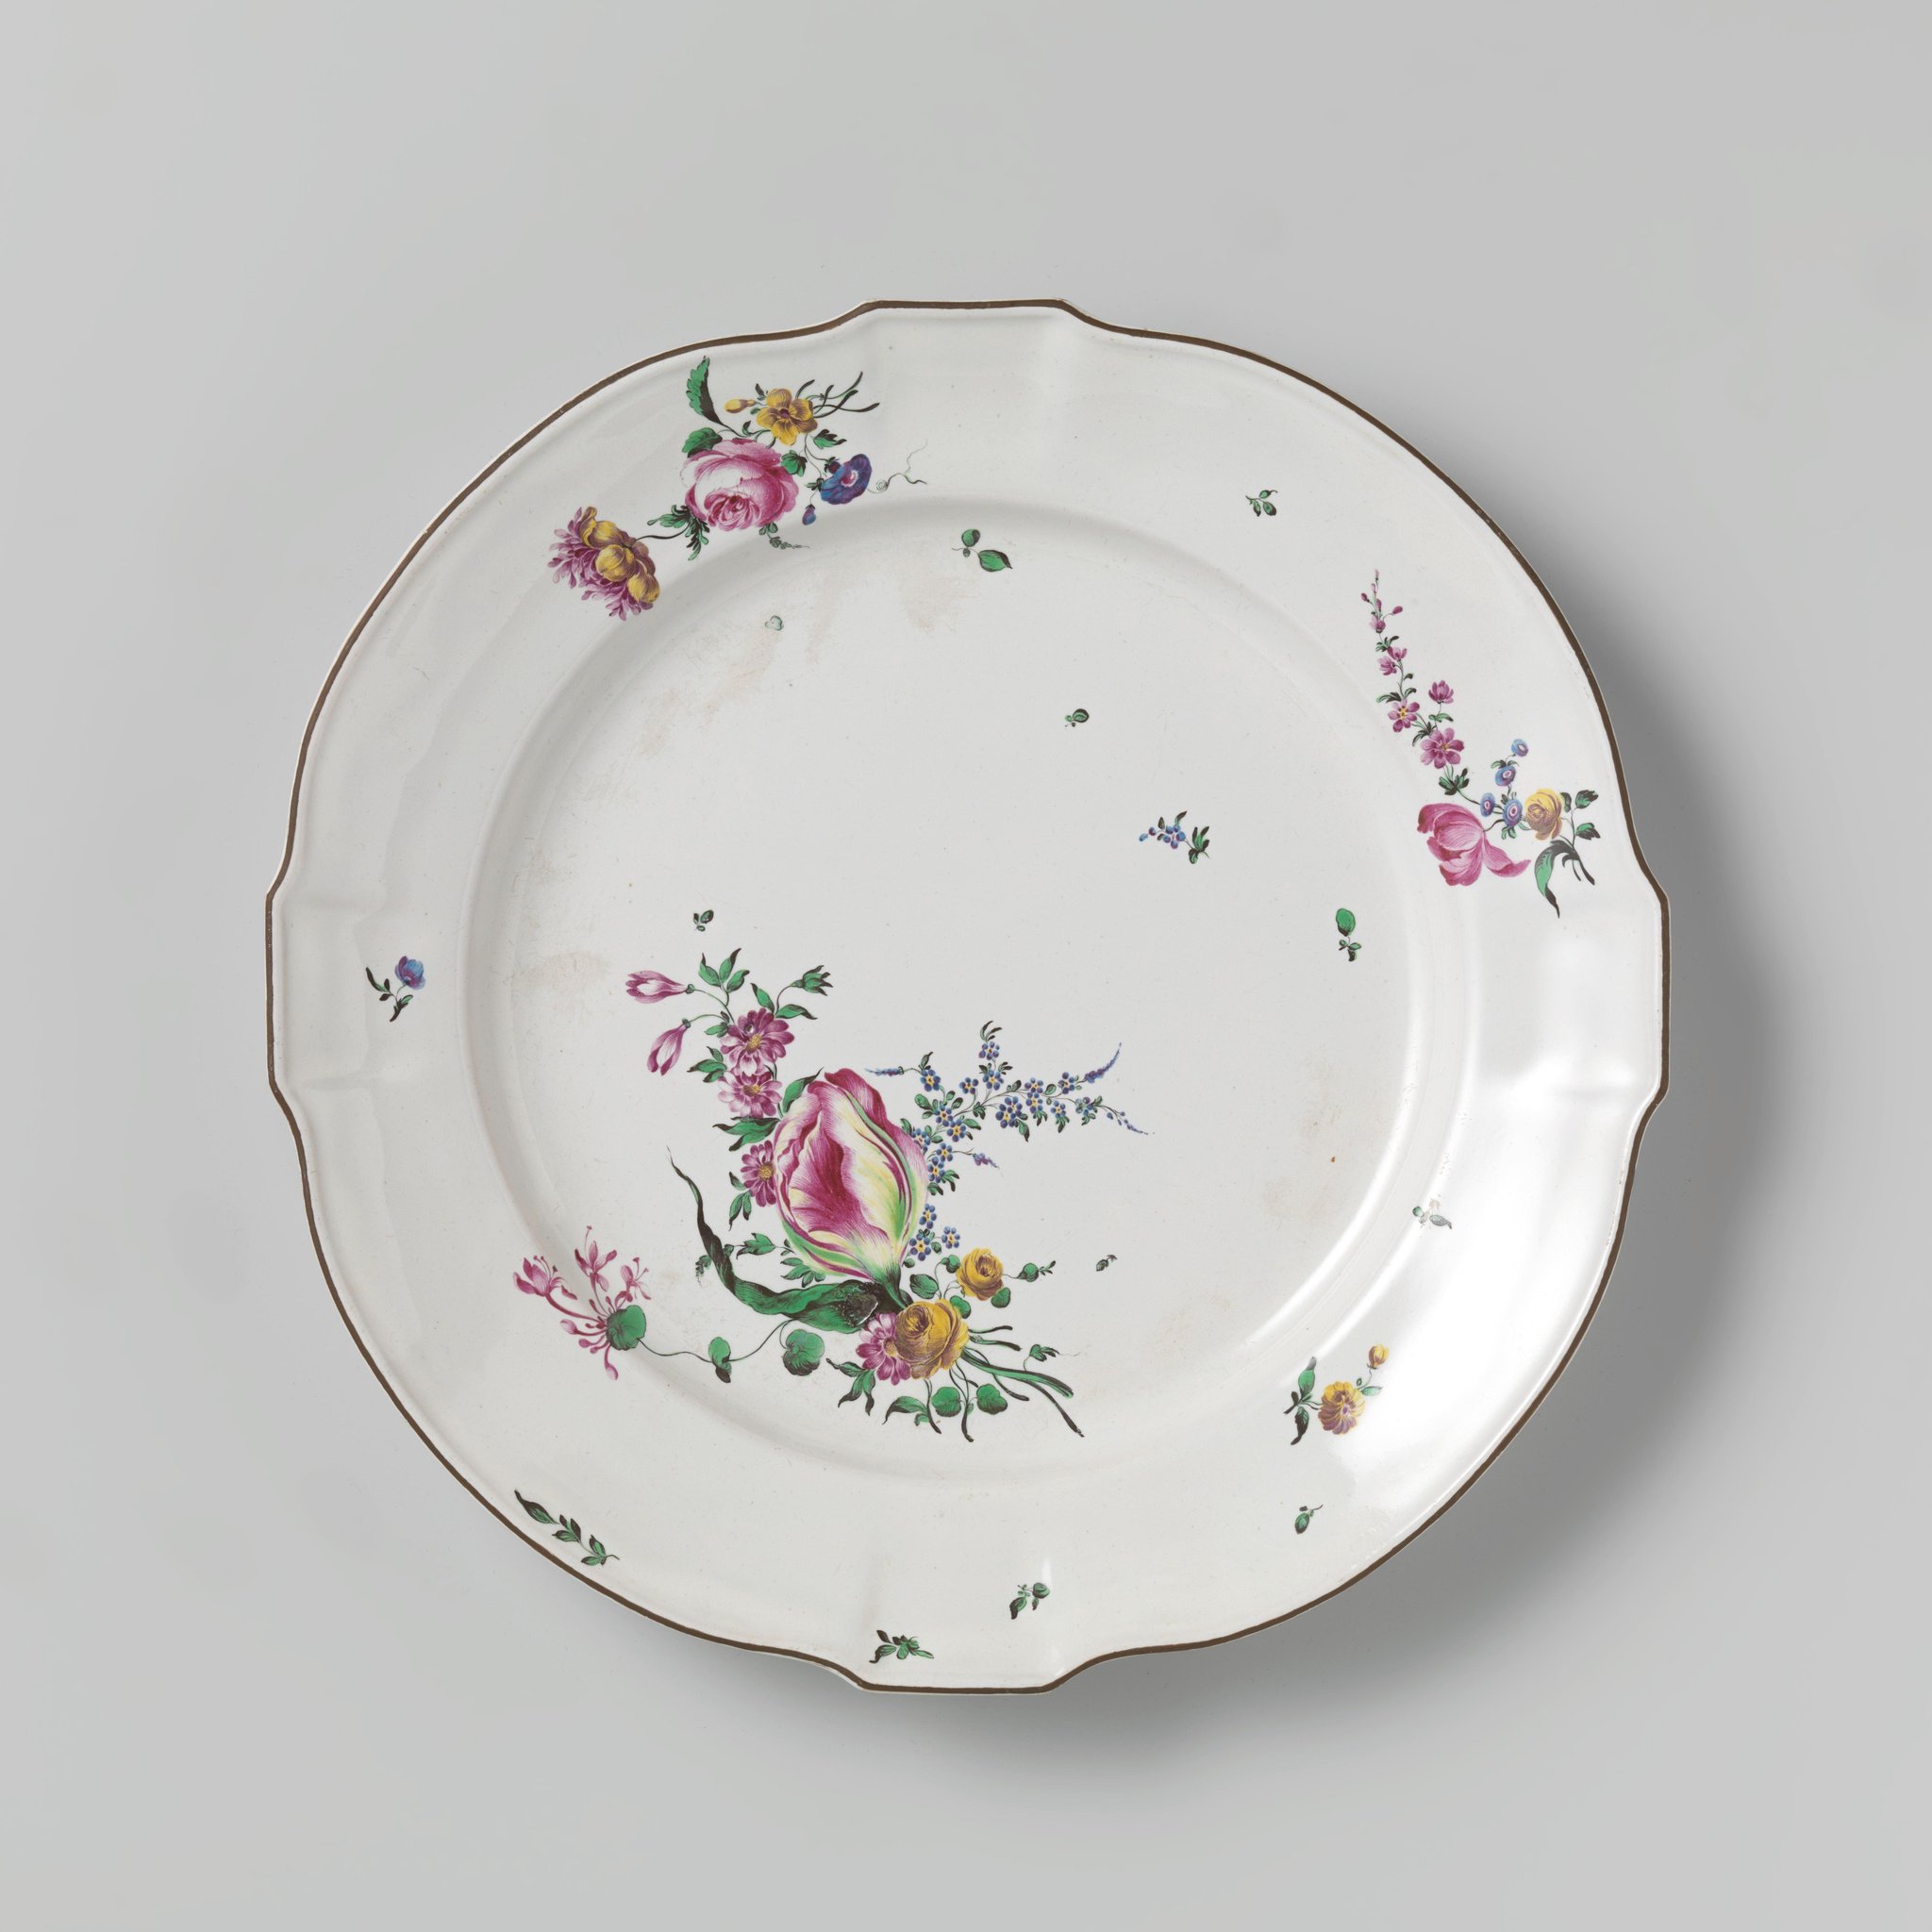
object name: tureen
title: Onderschotel van terrine met deksel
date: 1760-1775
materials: faience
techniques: kiln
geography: straatsburg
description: Onderschotel van ronde terrine met deksel van veelkleurig beschilderd met bloemboeketten en strooibloemen. Gemerkt J.H. en P.H.